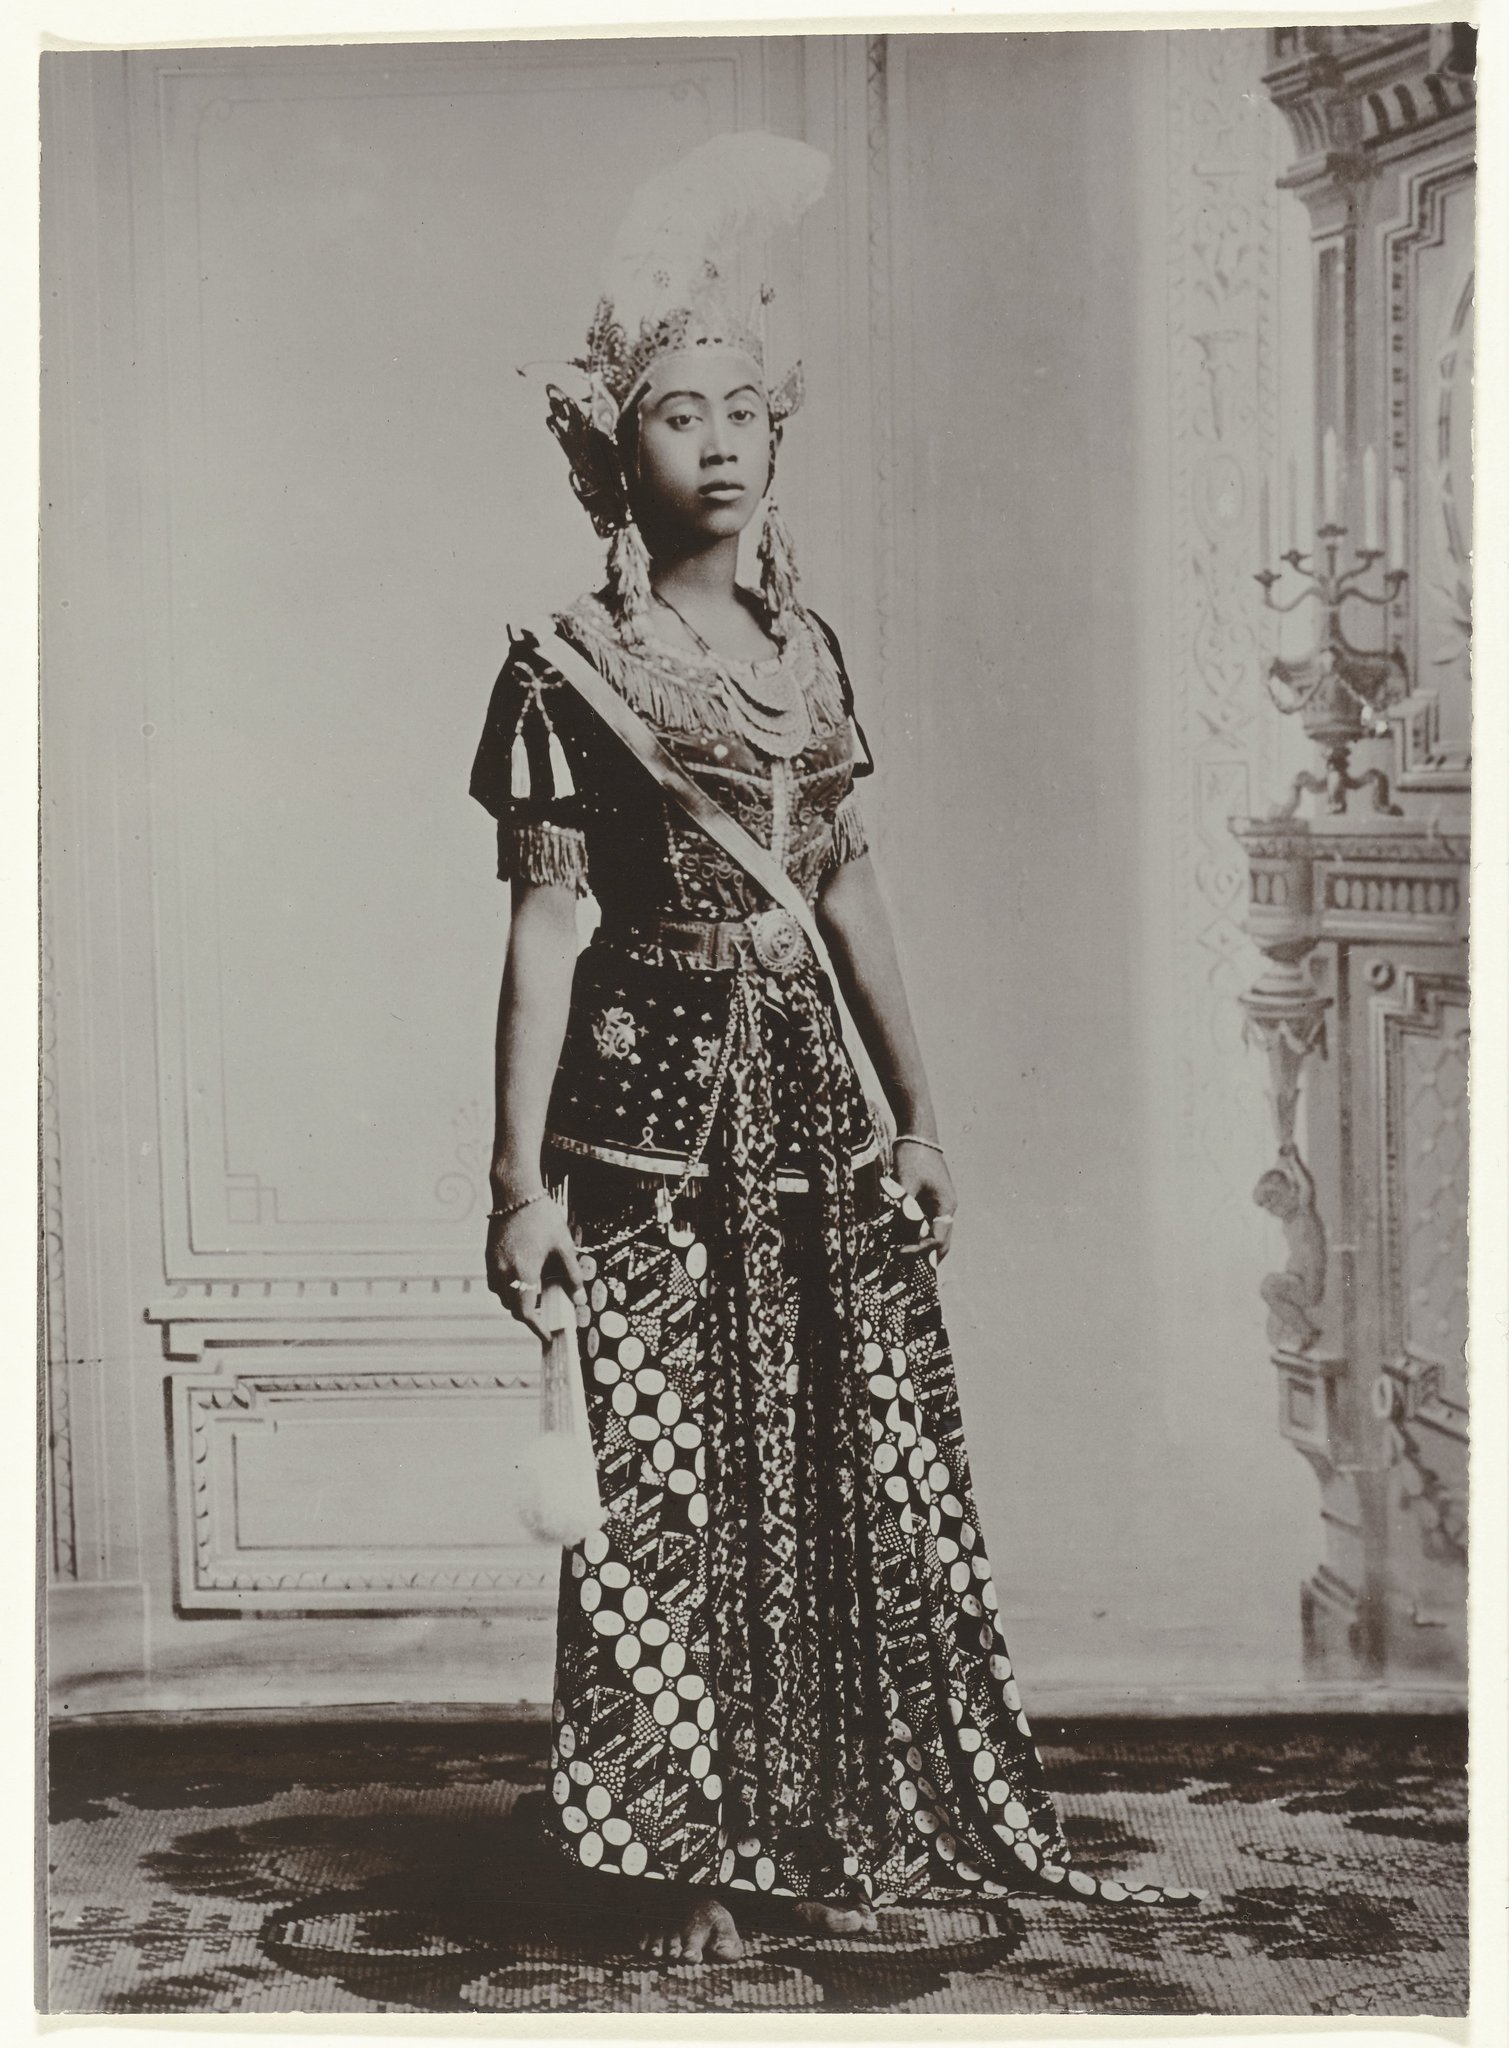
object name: photograph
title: Portret van een Javaanse vrouw met een waaier in de hand en een kroon op het hoofd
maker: kassian céphas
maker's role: fotograaf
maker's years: 1845-1912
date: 1867-1910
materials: cardboard, paper, photographic support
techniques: albumen print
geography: java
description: Portret van een Javaanse vrouw met een waaier in de hand en een kroon op het hoofd. Vermoedelijk is de vrouw een prinses uit het hof van Sultan Hamengkubuwana VII.